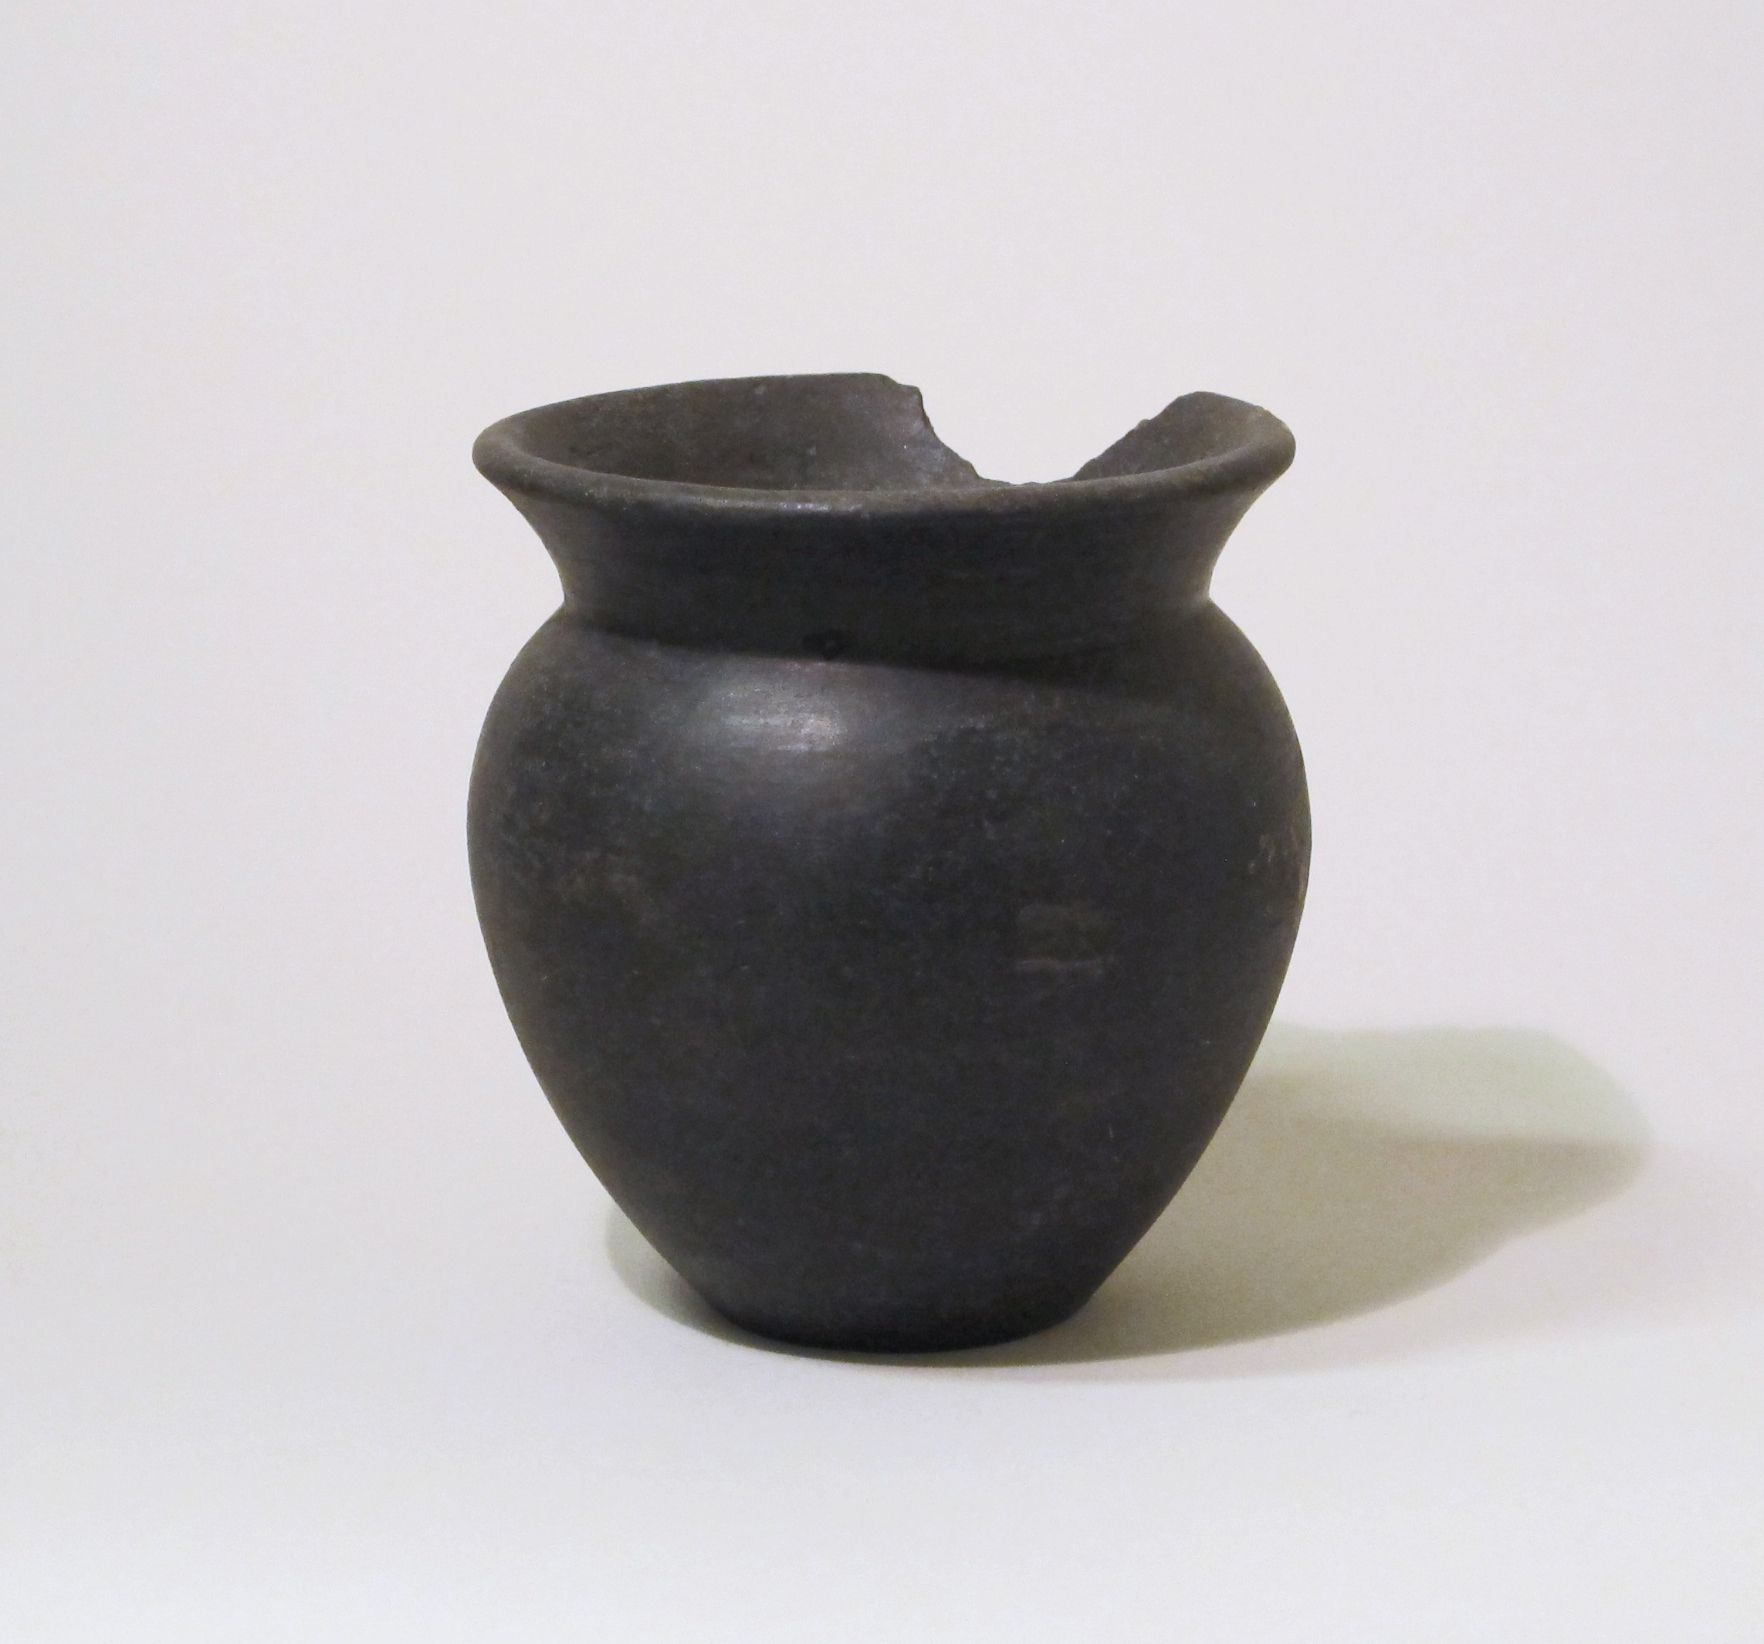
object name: focolare bowl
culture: etruscan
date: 550-501 BCE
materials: terracotta